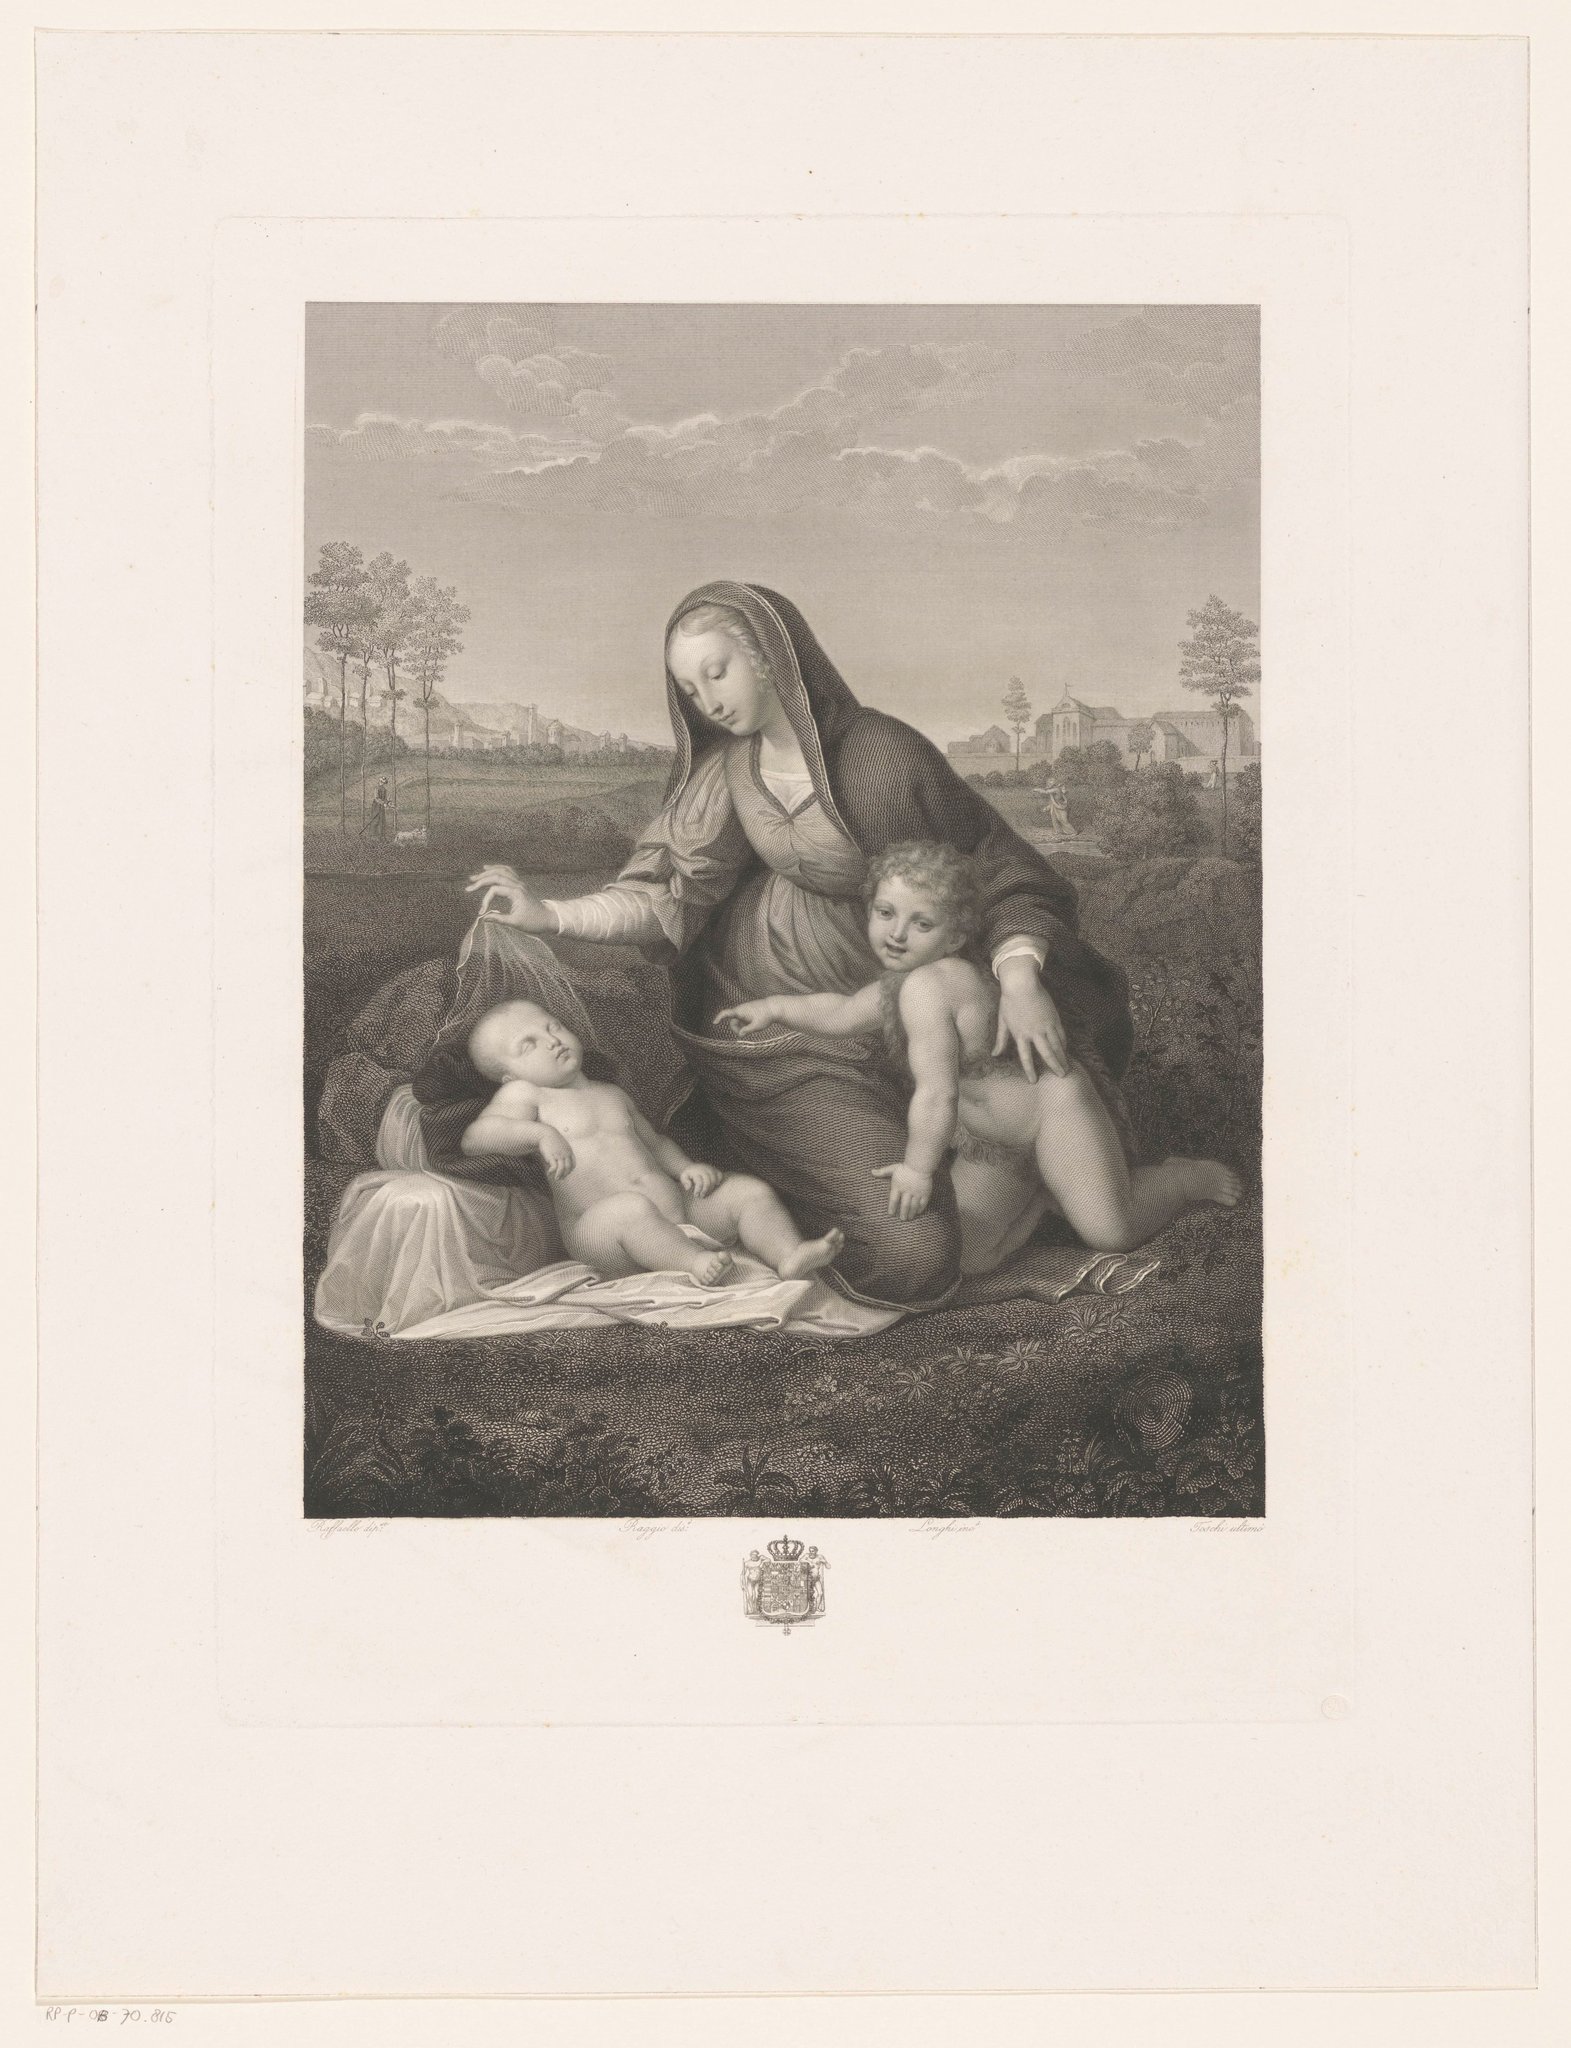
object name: print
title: Madonna del Velo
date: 1776-1831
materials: paper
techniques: engraving, etching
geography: italy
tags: mary and the christ-child with john the baptist (as child)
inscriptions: collector's mark: ‘GL’, collector's mark: Lugt 12